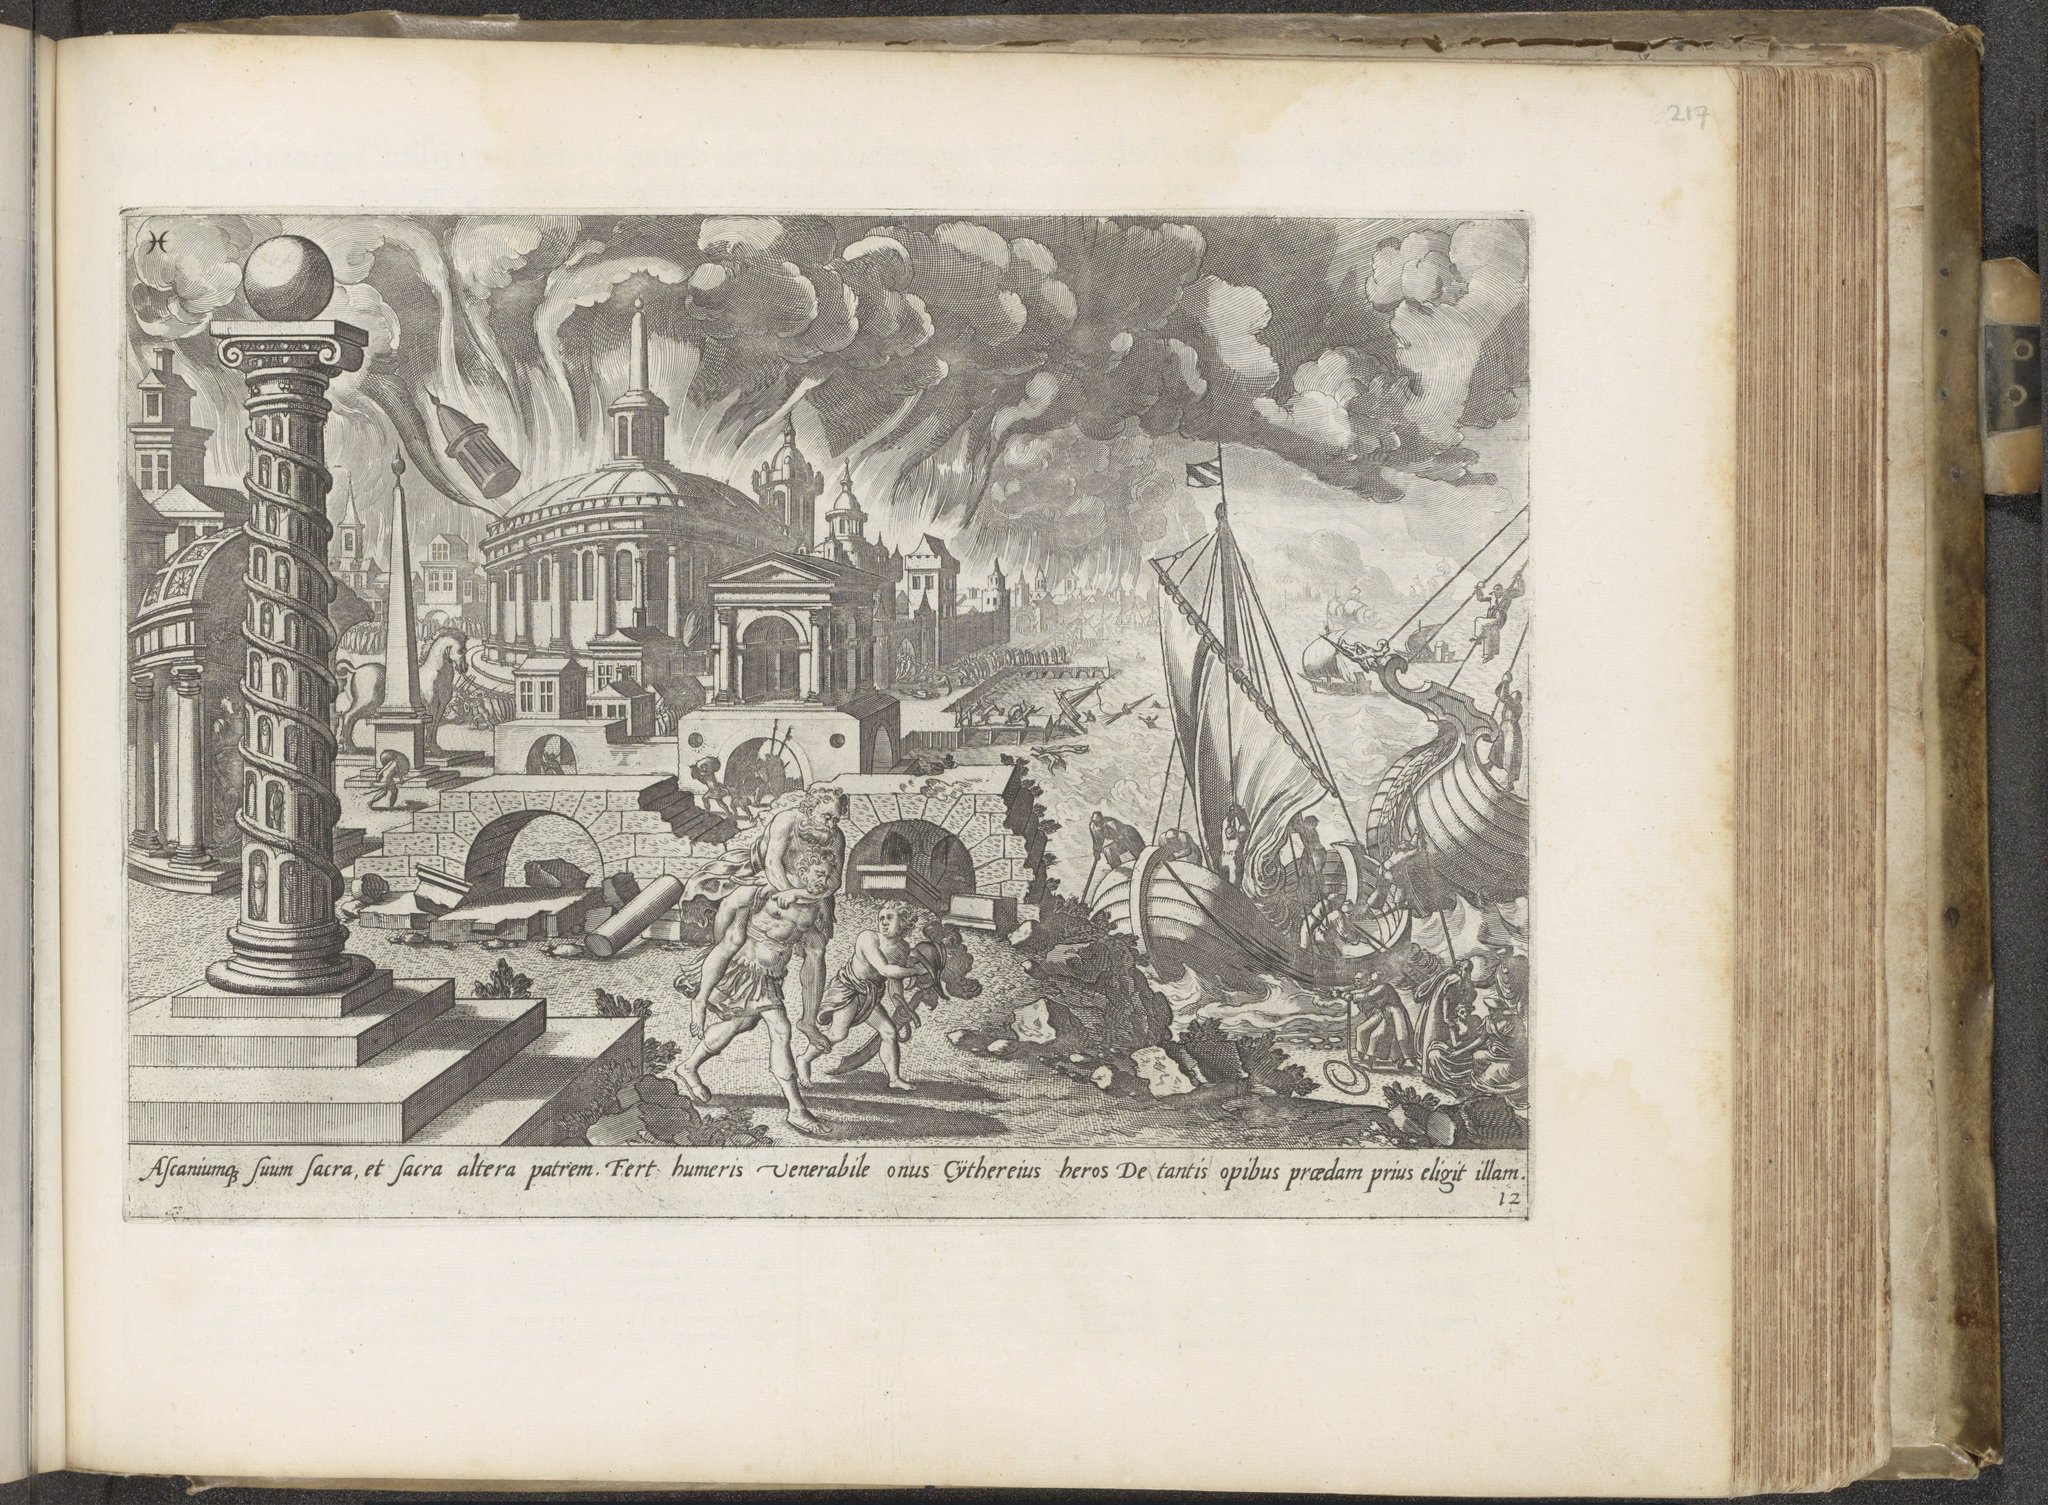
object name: album leaf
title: Metamorfosen van Ovidius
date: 1653-1654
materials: paper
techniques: etching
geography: amsterdam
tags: 'pius aeneas': aeneas, leading ascanius, escapes from burning troy, carrying his father anchises with the penates; his wife creusa, who sets out with them, is lost on the way, pisces (zodiacal sign of february)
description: Aeneas vlucht met zijn vader Anchises op zijn rug en vergezeld van zijn zoon Ascanius uit het brandende Troje. Onder de voorstelling de tekst uit de Metamorfosen van Ovidius, boek 13, versregels 624-626. Bovenaan het teken van Vissen uit de dierenriem. De prent maakt deel uit van een album.